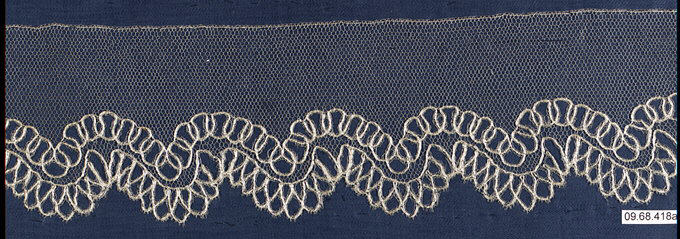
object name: bobbin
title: Silk bobbin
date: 1801-1900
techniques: lace